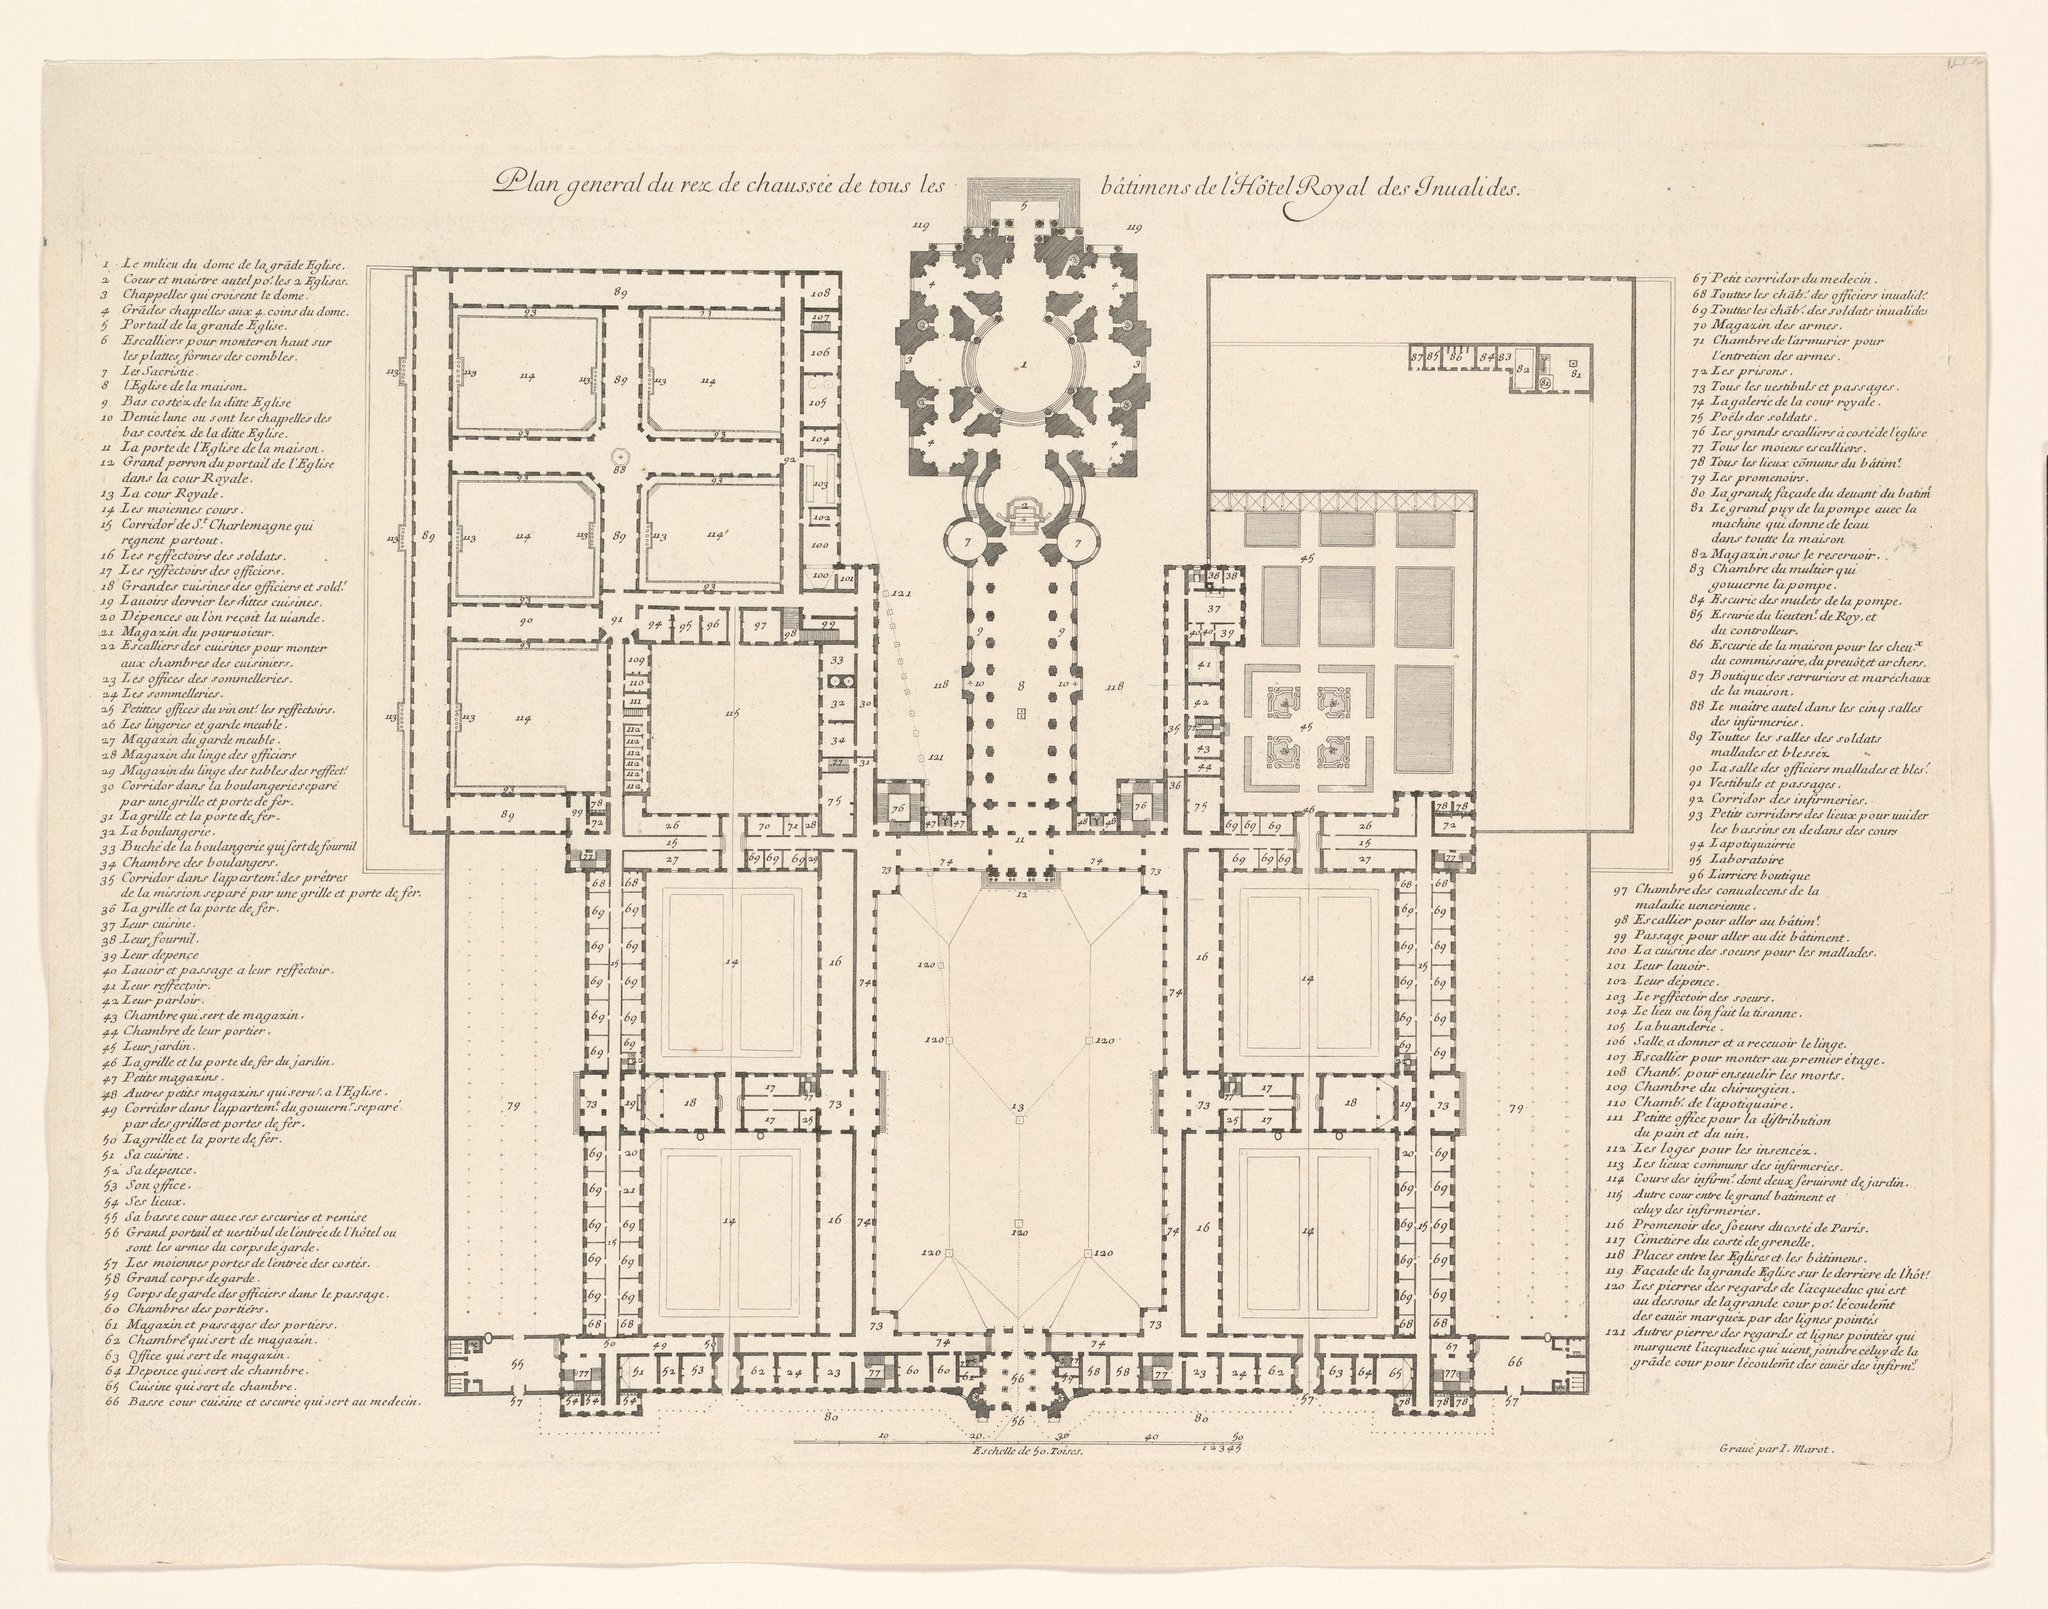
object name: area plan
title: Plan general du rez de chaussée de tous les bâtimens de l'Hôtel Royal des Invalides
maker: jean marot (i)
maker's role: print maker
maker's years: 1619-1679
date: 1670-1679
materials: paper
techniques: etching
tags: plan ~ architecture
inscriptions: collector's mark: Lugt 2228